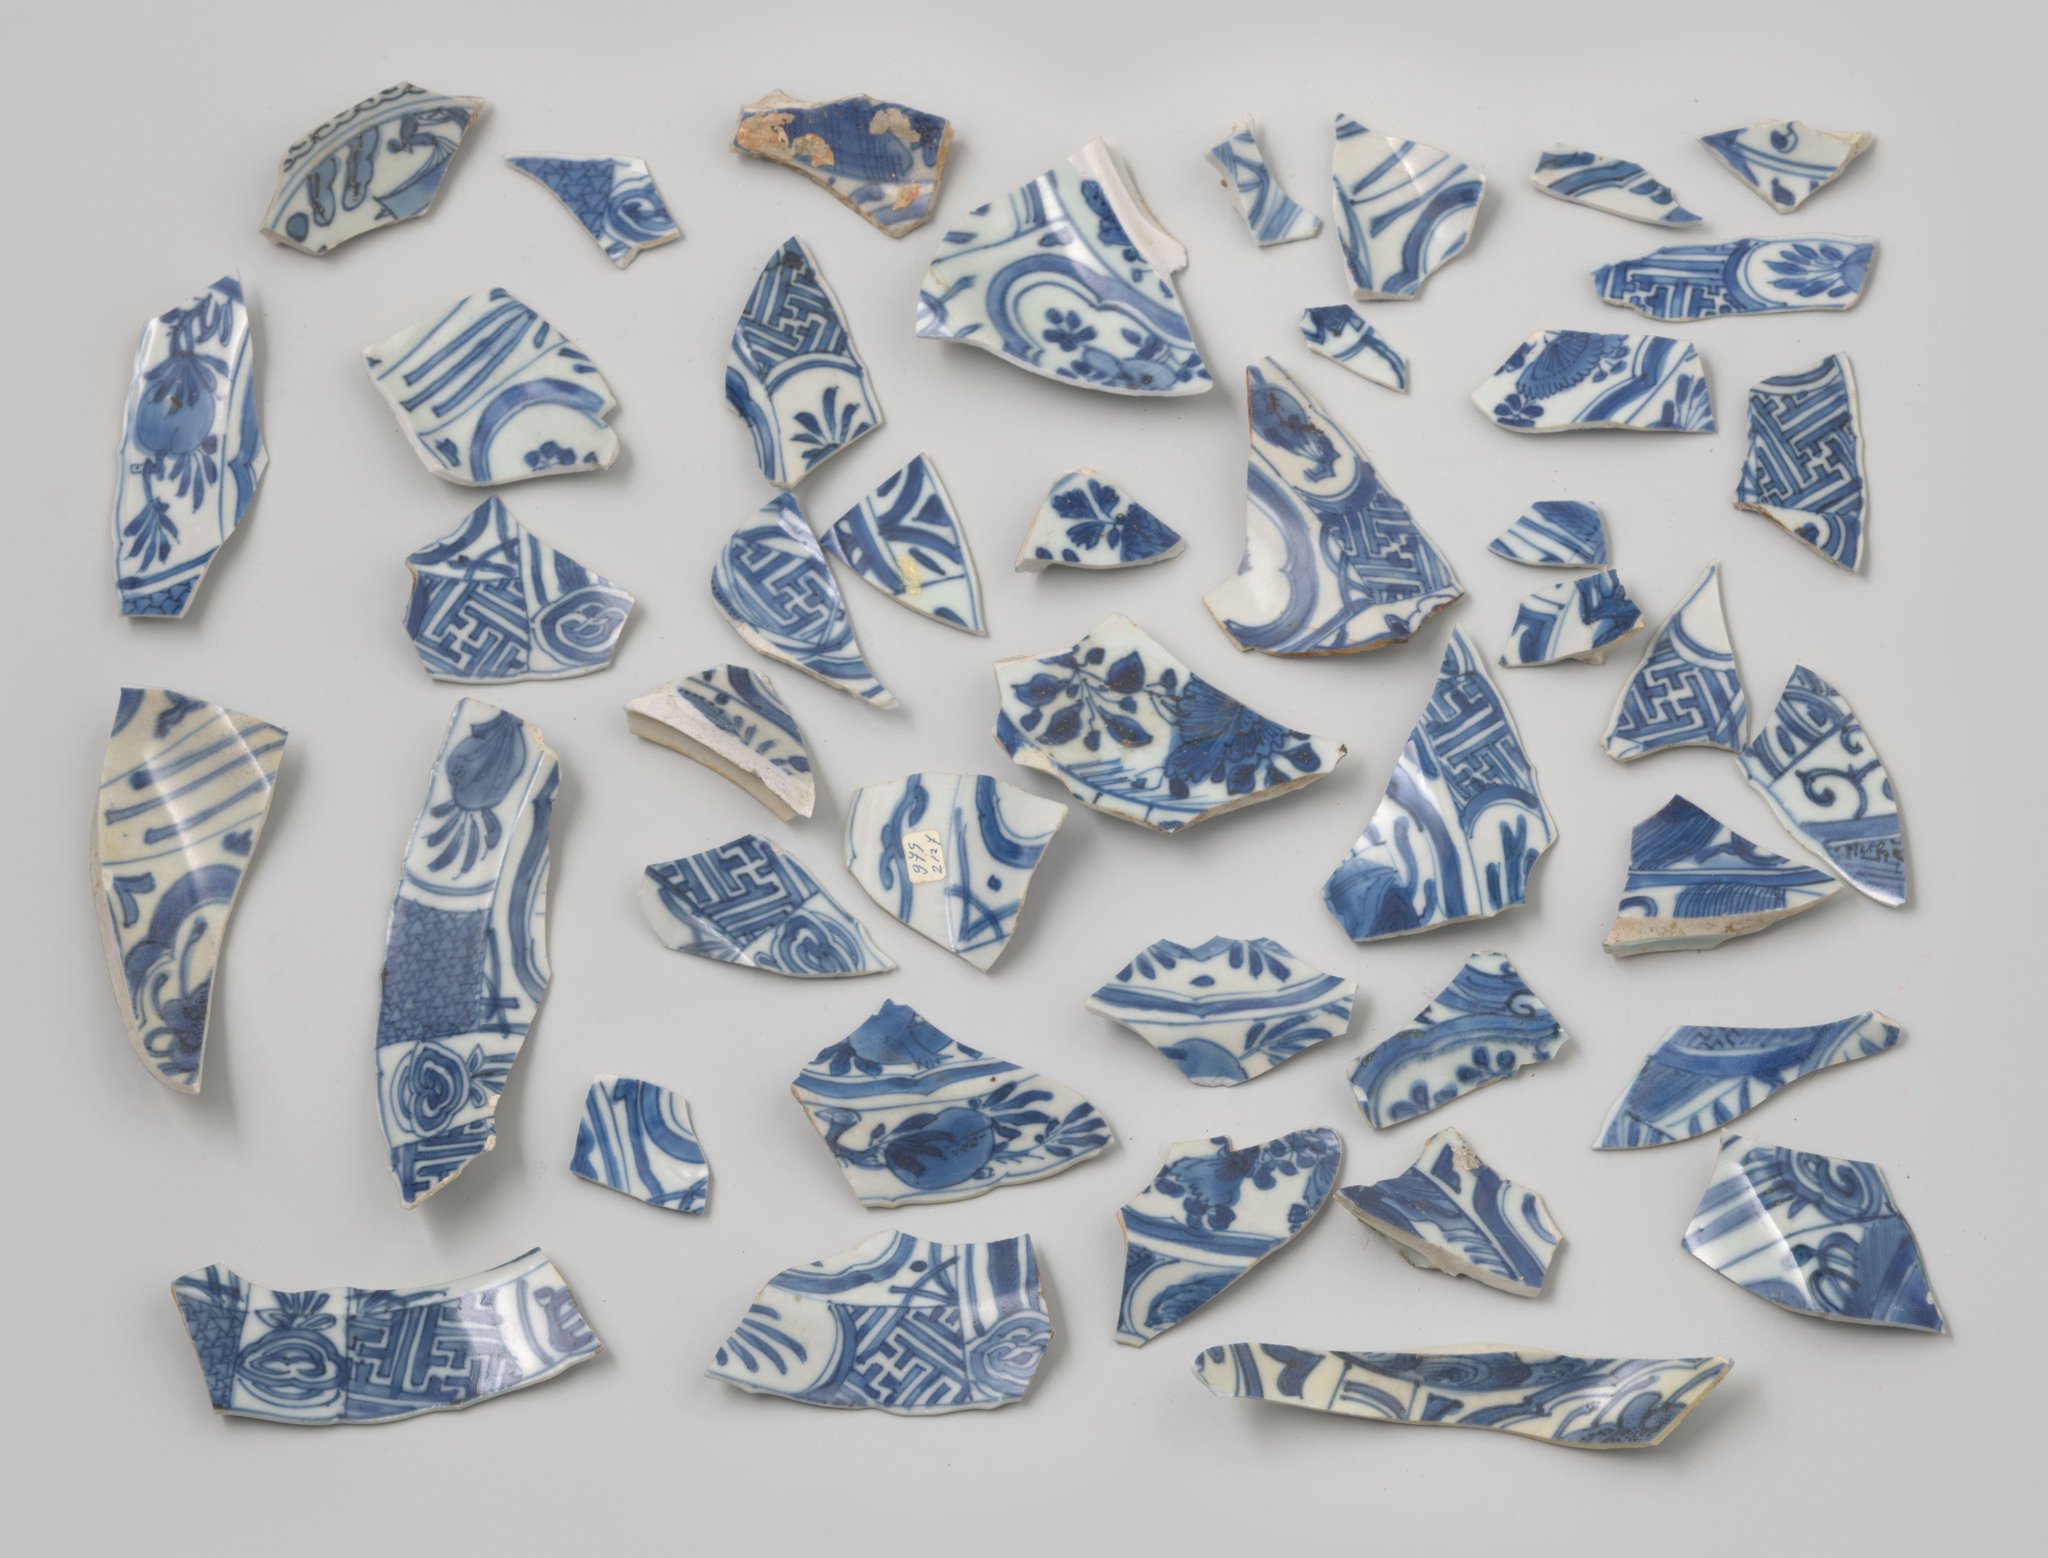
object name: sherd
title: Scherven kraakporselein uit V.O.C.-schip de 'Witte Leeuw'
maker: Anonymous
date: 1613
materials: bone china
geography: jingdezhen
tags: verenigde oostindische compagnie, sint-helena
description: Scherven kraakporseleinen borden uit V.O.C.-schip de 'Witte Leeuw'.